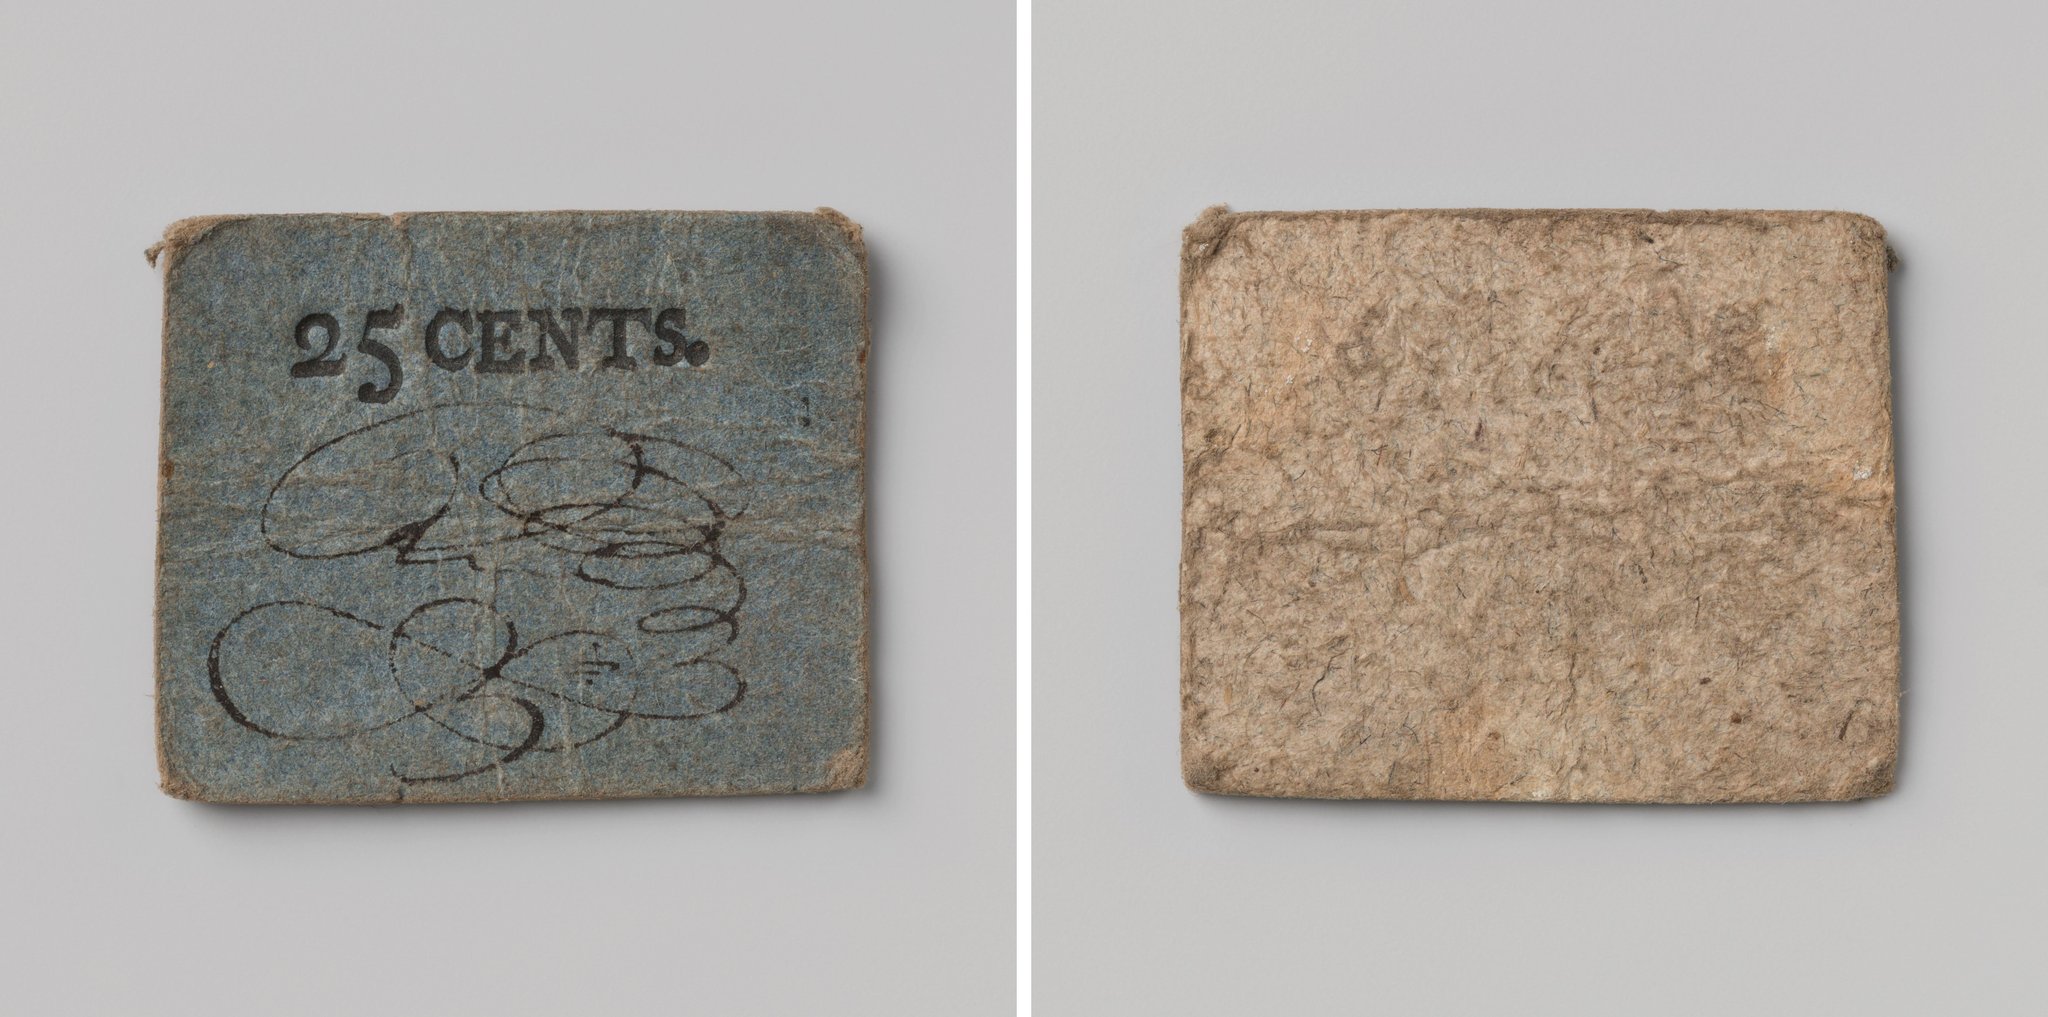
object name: vijfentwintig cent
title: Huismunt (winkelkaart) ter waarde van 25 cent van de Kolonien van Weldadigheid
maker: william reese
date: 1821-1826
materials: cardboard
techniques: printing, writing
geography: frederiksoord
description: Eenzijdige, rechthoekige munt van karton dat aan voorzijde blauw en aan keerzijde wit is gekleurd. Voorzijde: waardeaanduiding boven met zwarte inkt geschreven handtekening. Keerzijde: blanco.